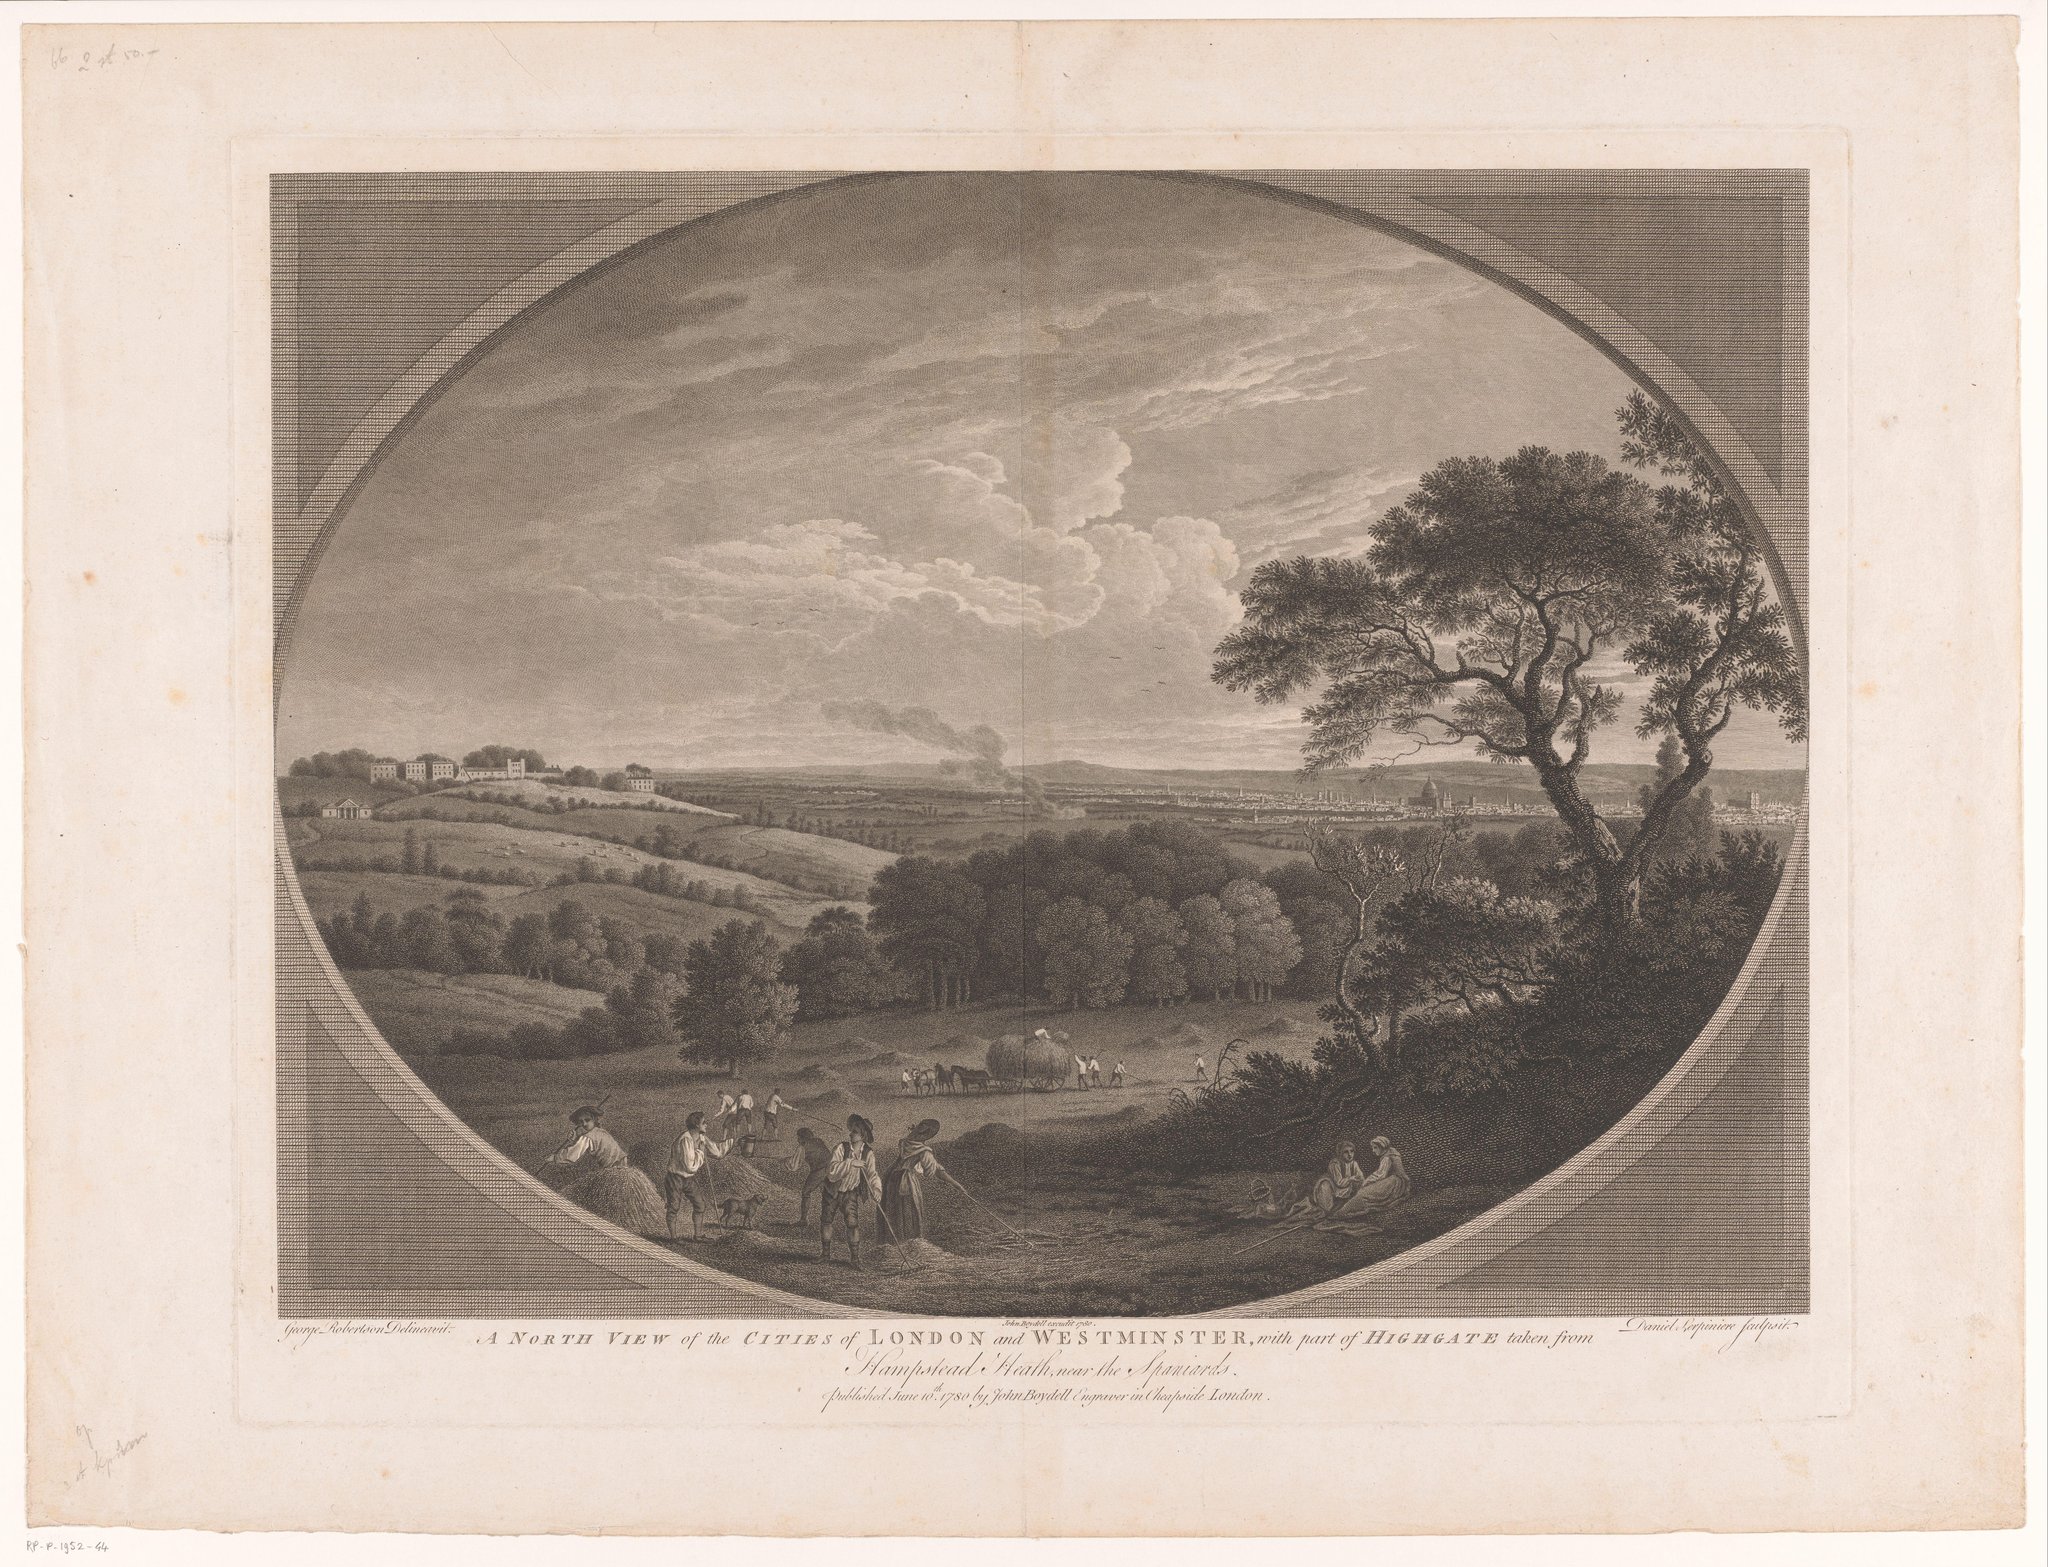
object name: print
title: Gezicht op Londen, gezien vanaf Hamptead Heath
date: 1780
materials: paper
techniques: engraving, etching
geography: london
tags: outskirts of city, reaping, picking, mowing ~ harvest, london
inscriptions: collector's mark: Lugt 2228